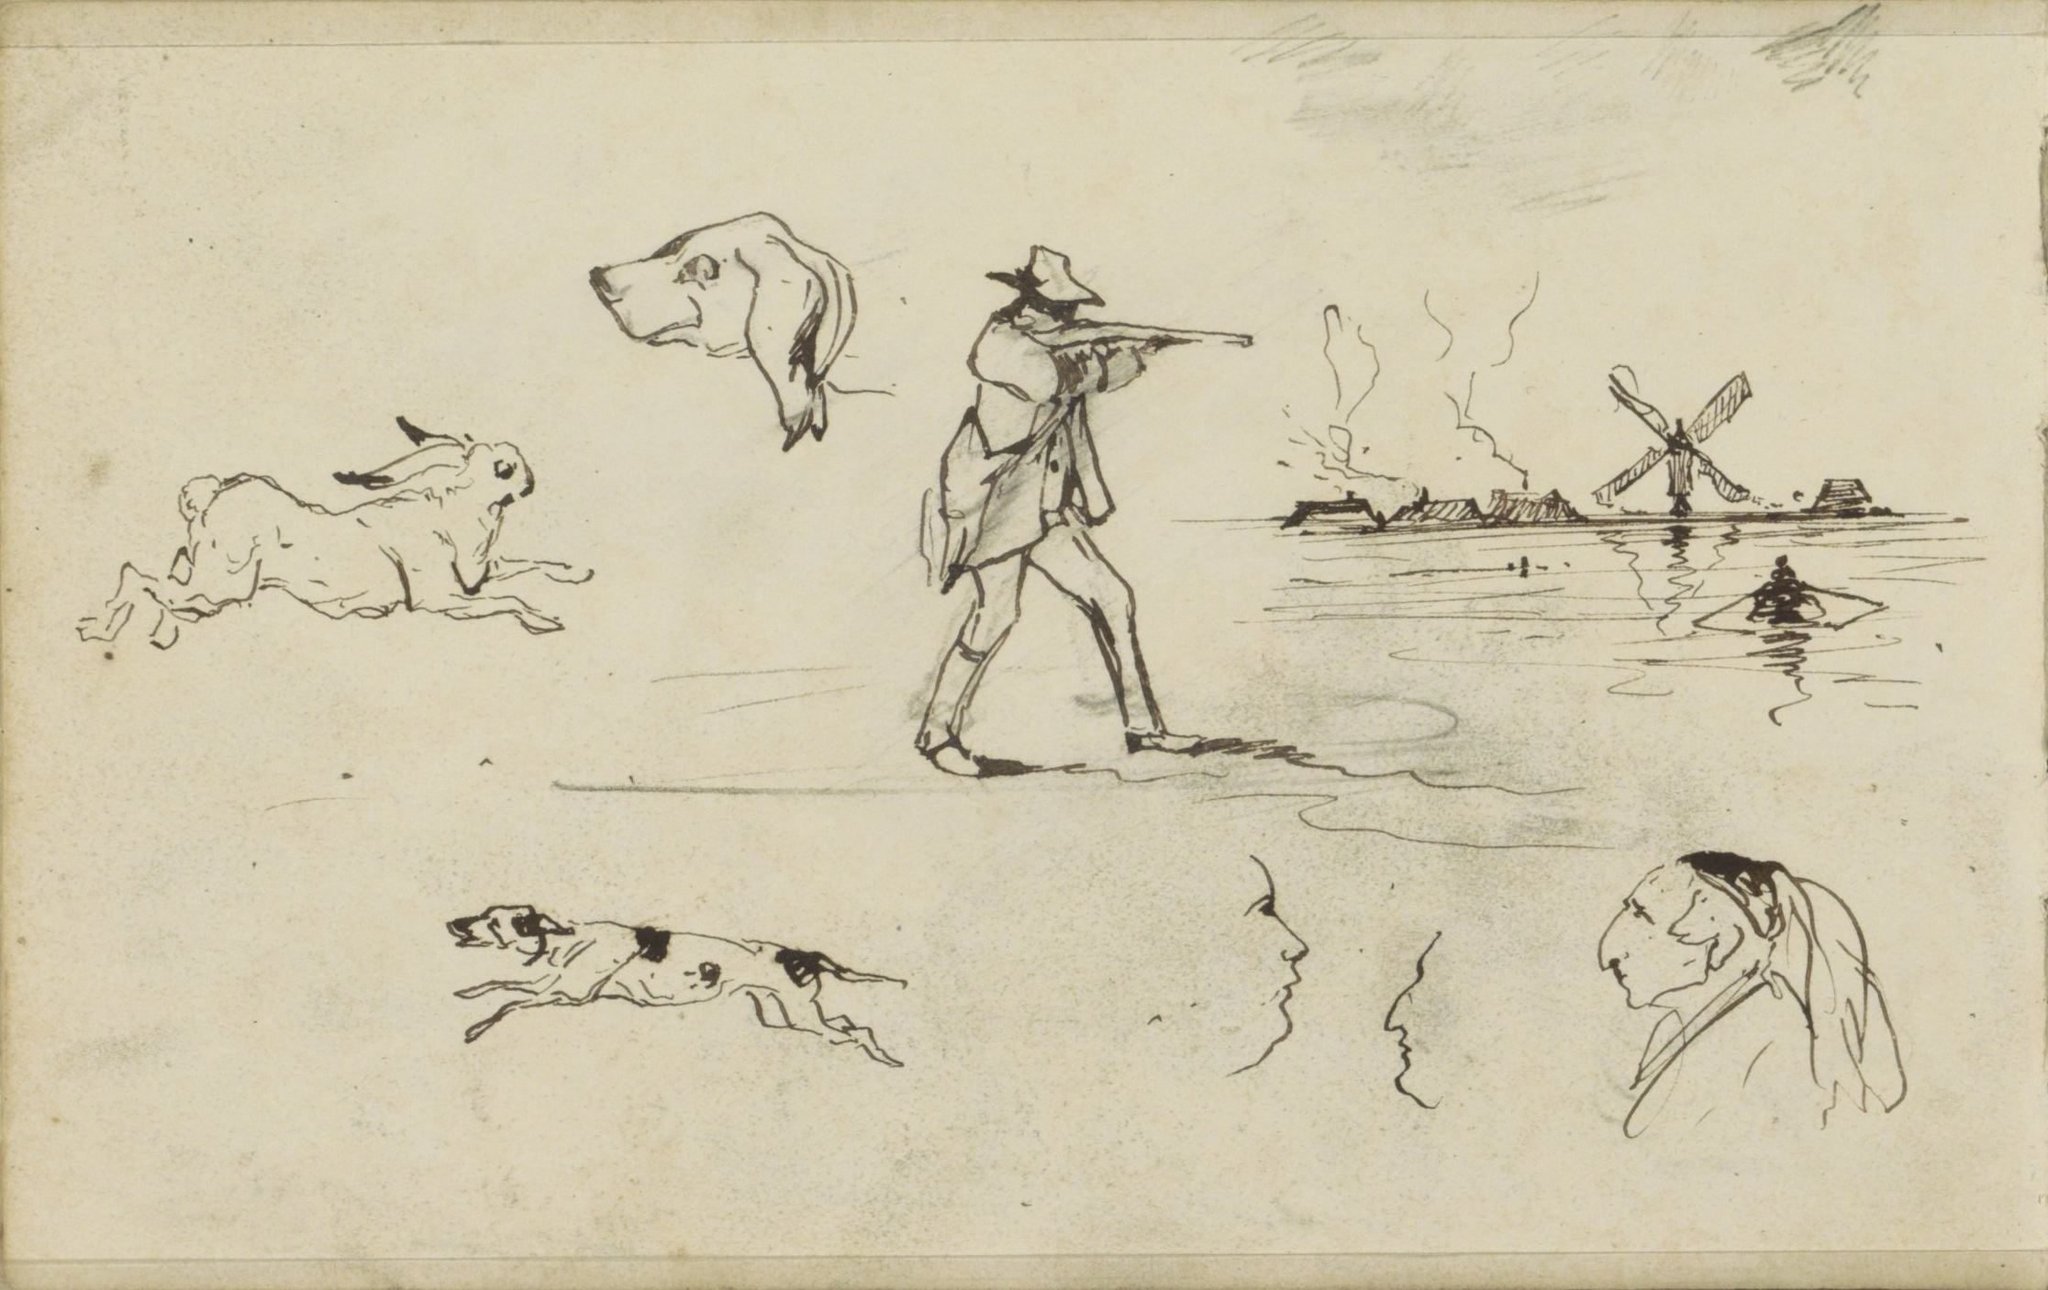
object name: sketchbook leaf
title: Studieblad, onder andere met een jager en landschap met molen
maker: johannes tavenraat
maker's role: draughtsman, painter, print maker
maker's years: 1809-1881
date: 1839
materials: paper, pencil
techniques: pen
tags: head (human), hunter, factories and mills in landscape, rodents, dog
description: Tevens studies van een haas, honden en vrouwenkoppen. Blad 17 verso uit een schetsboek met 37 bladen.